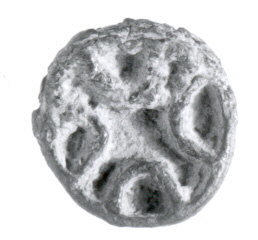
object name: stamp seal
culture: bactria-margiana archaeological complex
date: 2333-1668 BCE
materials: copper alloy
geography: bactria-margiana